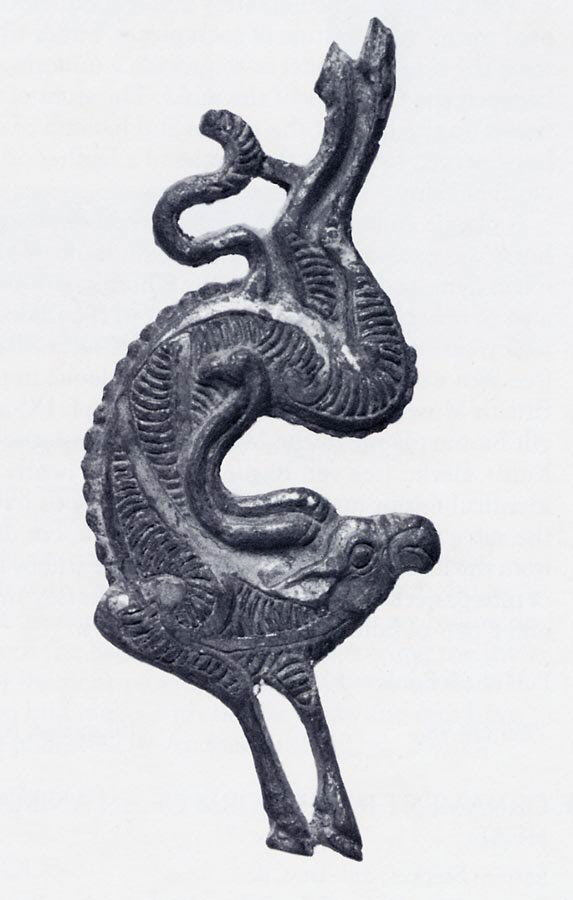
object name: plaque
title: Plaque in the Shape of an Ibex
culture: north chinese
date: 300-1 BCE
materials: gilt bronze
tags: ibex